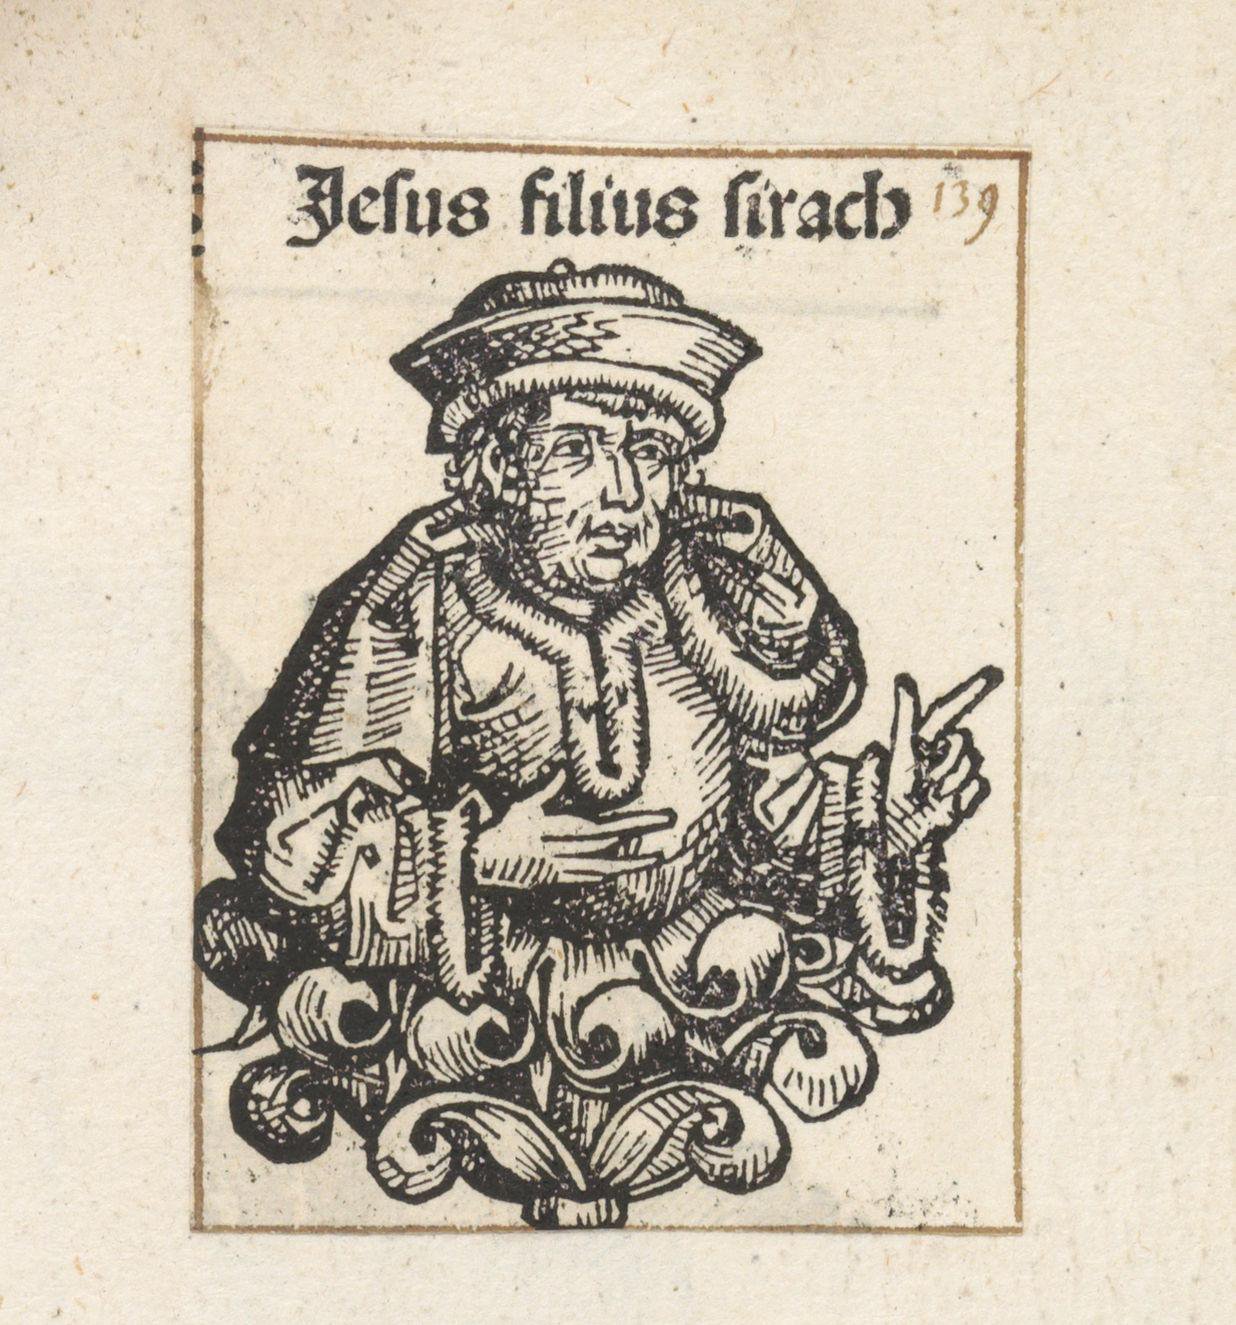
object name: album leaf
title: Liber Chronicarum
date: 1493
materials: paper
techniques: letterpress printing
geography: nuremberg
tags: persons from the old testament (not in biblical context, nor occurring in legendary/historical extensions included in division 71)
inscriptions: inscription: ‘139’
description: De houtsnede wordt gebruikt als boekillustratie in de Liber Chronicarum (of Neurenbergkroniek) van Hartmann Schedel, verschenen in het Latijn en Duits in 1493. Zie de Latijnse uitgave, folio 72v.